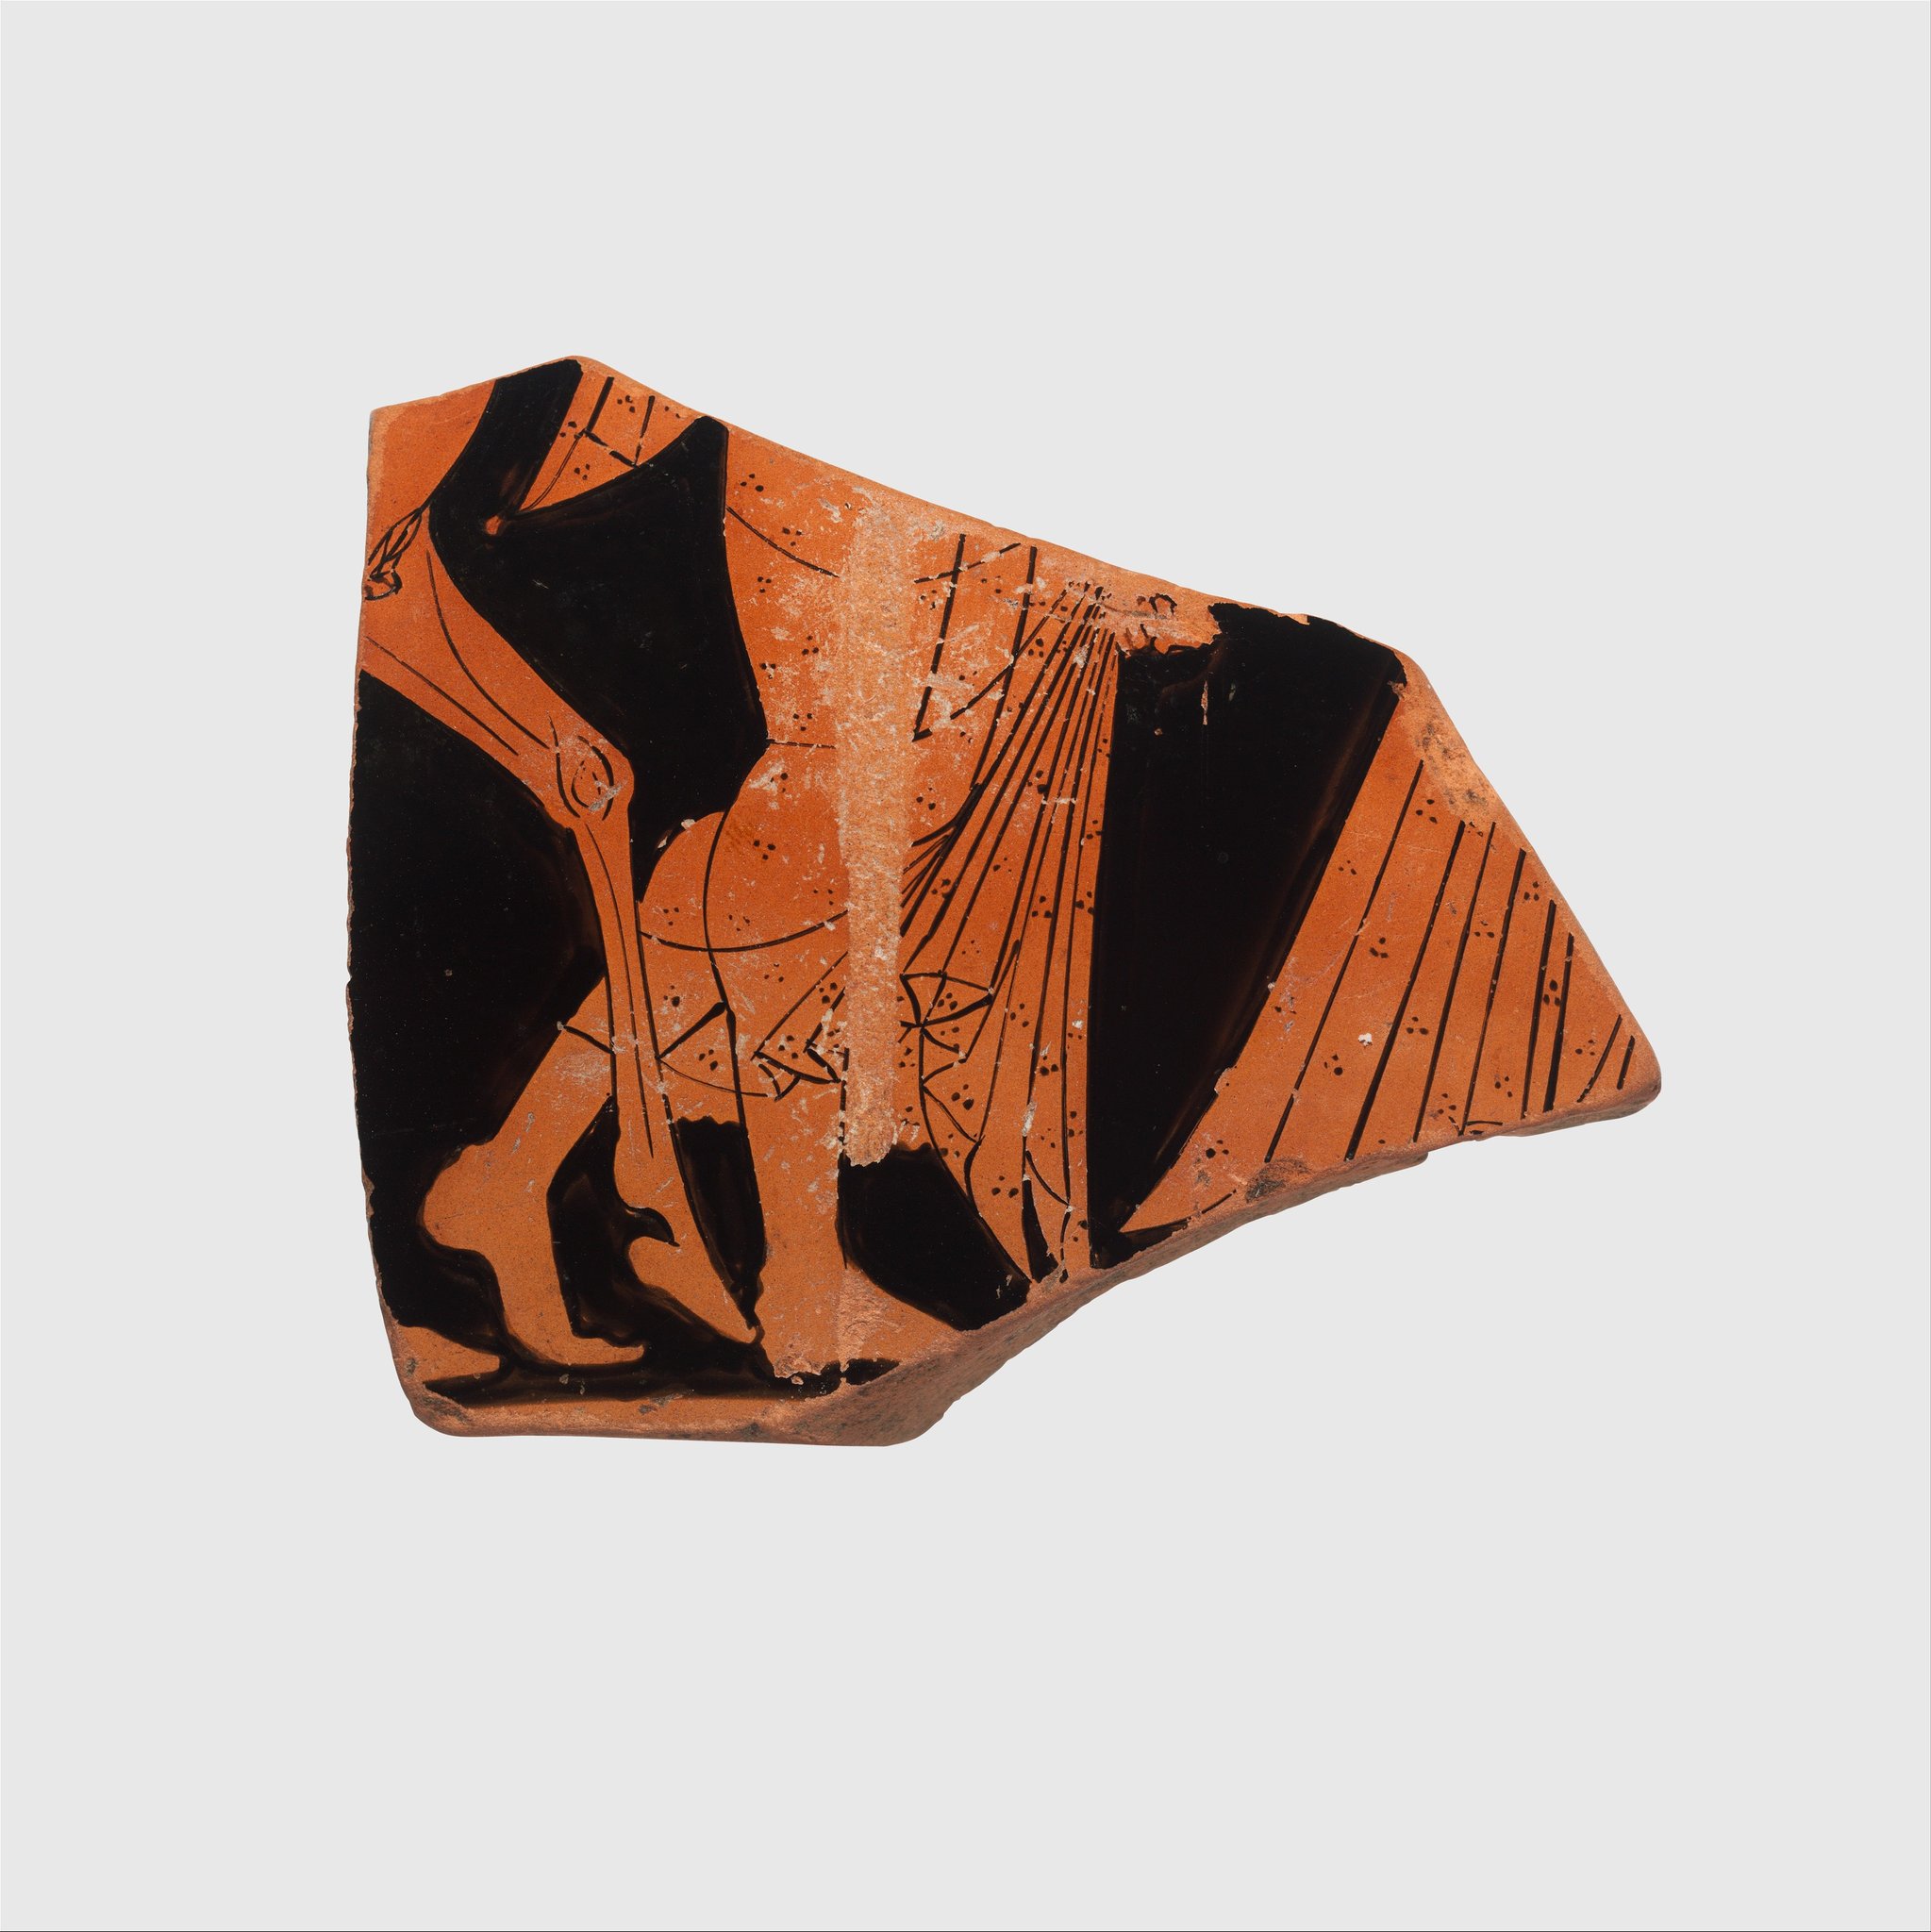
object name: kylix fragment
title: Fragment of a terracotta kylix (drinking cup)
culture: greek, attic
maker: euphronios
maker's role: artist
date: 520-510 BCE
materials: terracotta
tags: legs